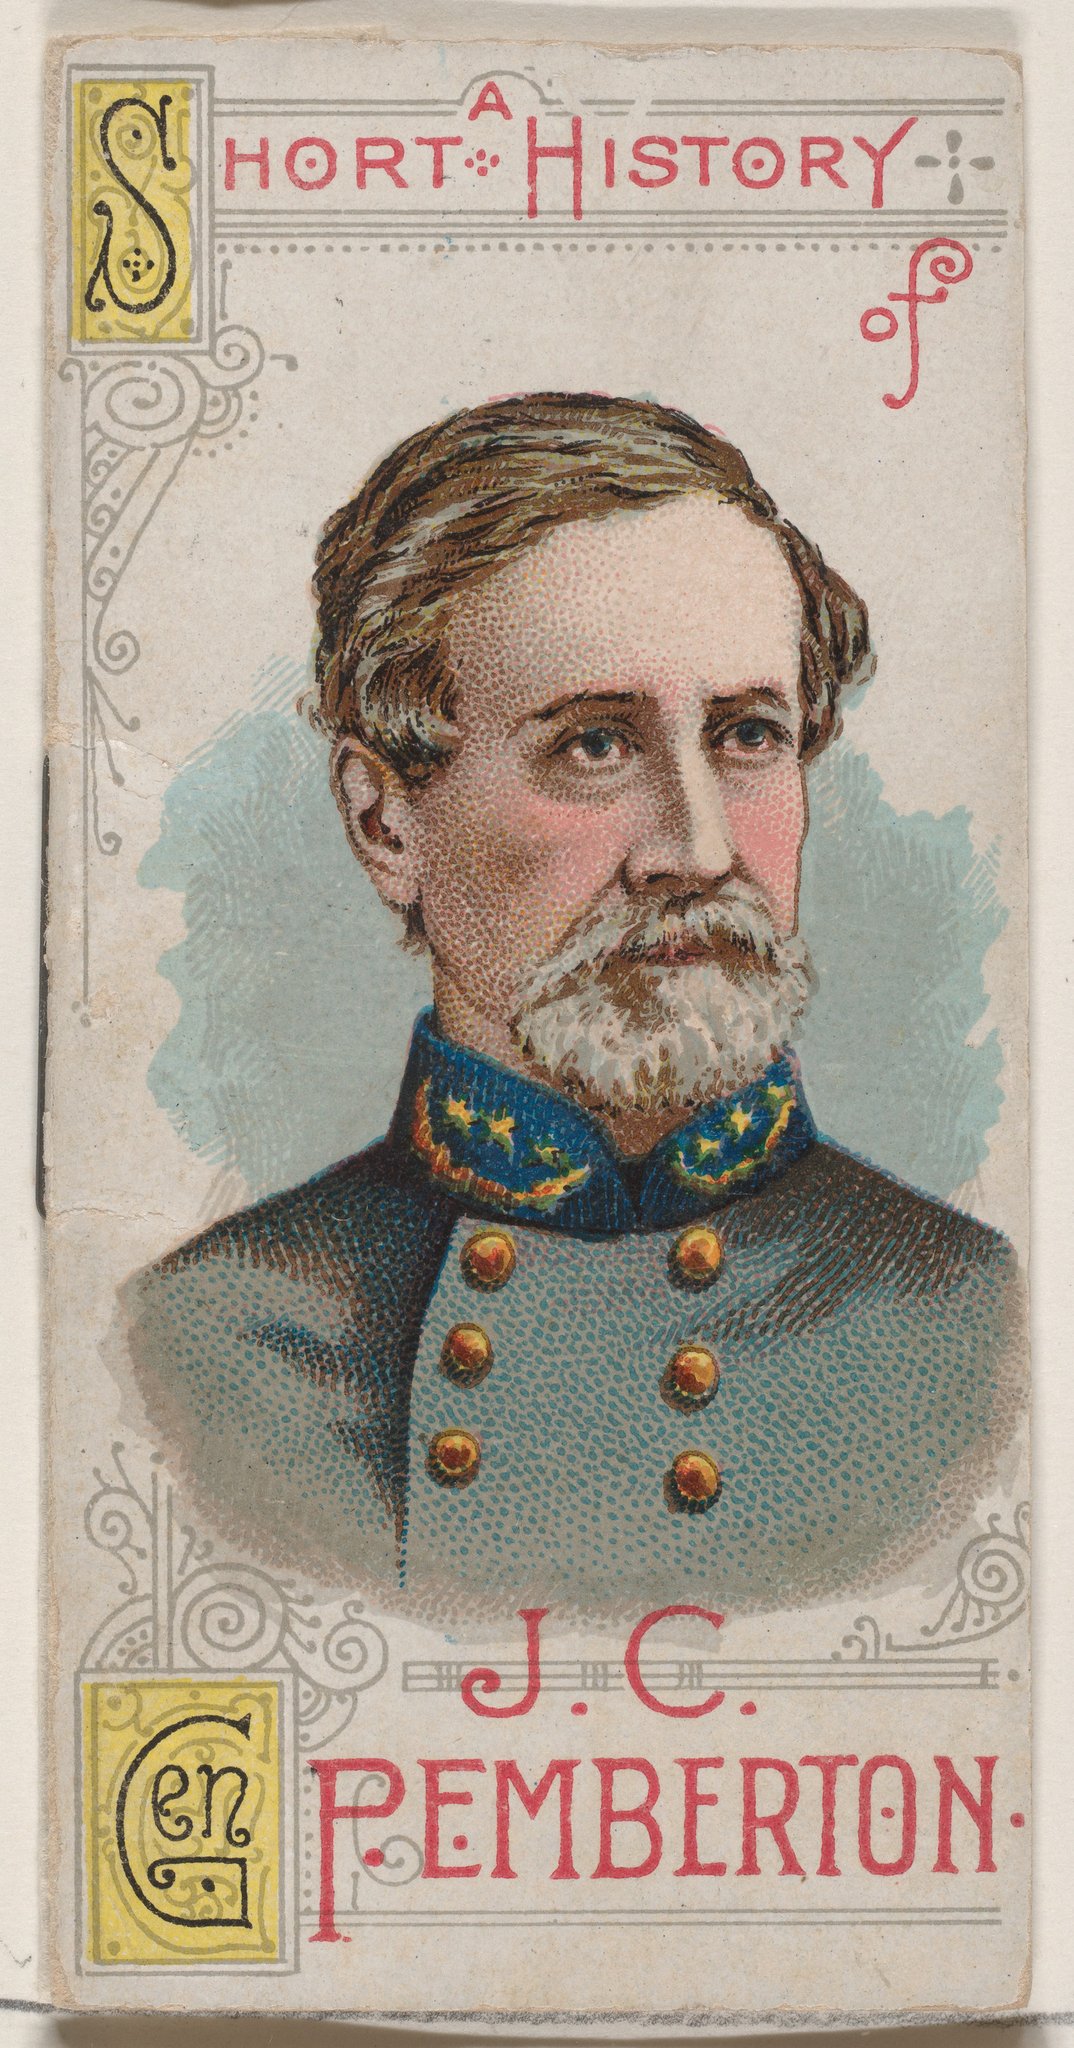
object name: print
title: A Short History of General John Clifford Pemberton, from the Histories of Generals series of booklets (N78) for Duke brand cigarettes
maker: w. duke, sons & co.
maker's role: publisher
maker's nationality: american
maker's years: 1870-1920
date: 1888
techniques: color lithograph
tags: men,portraits